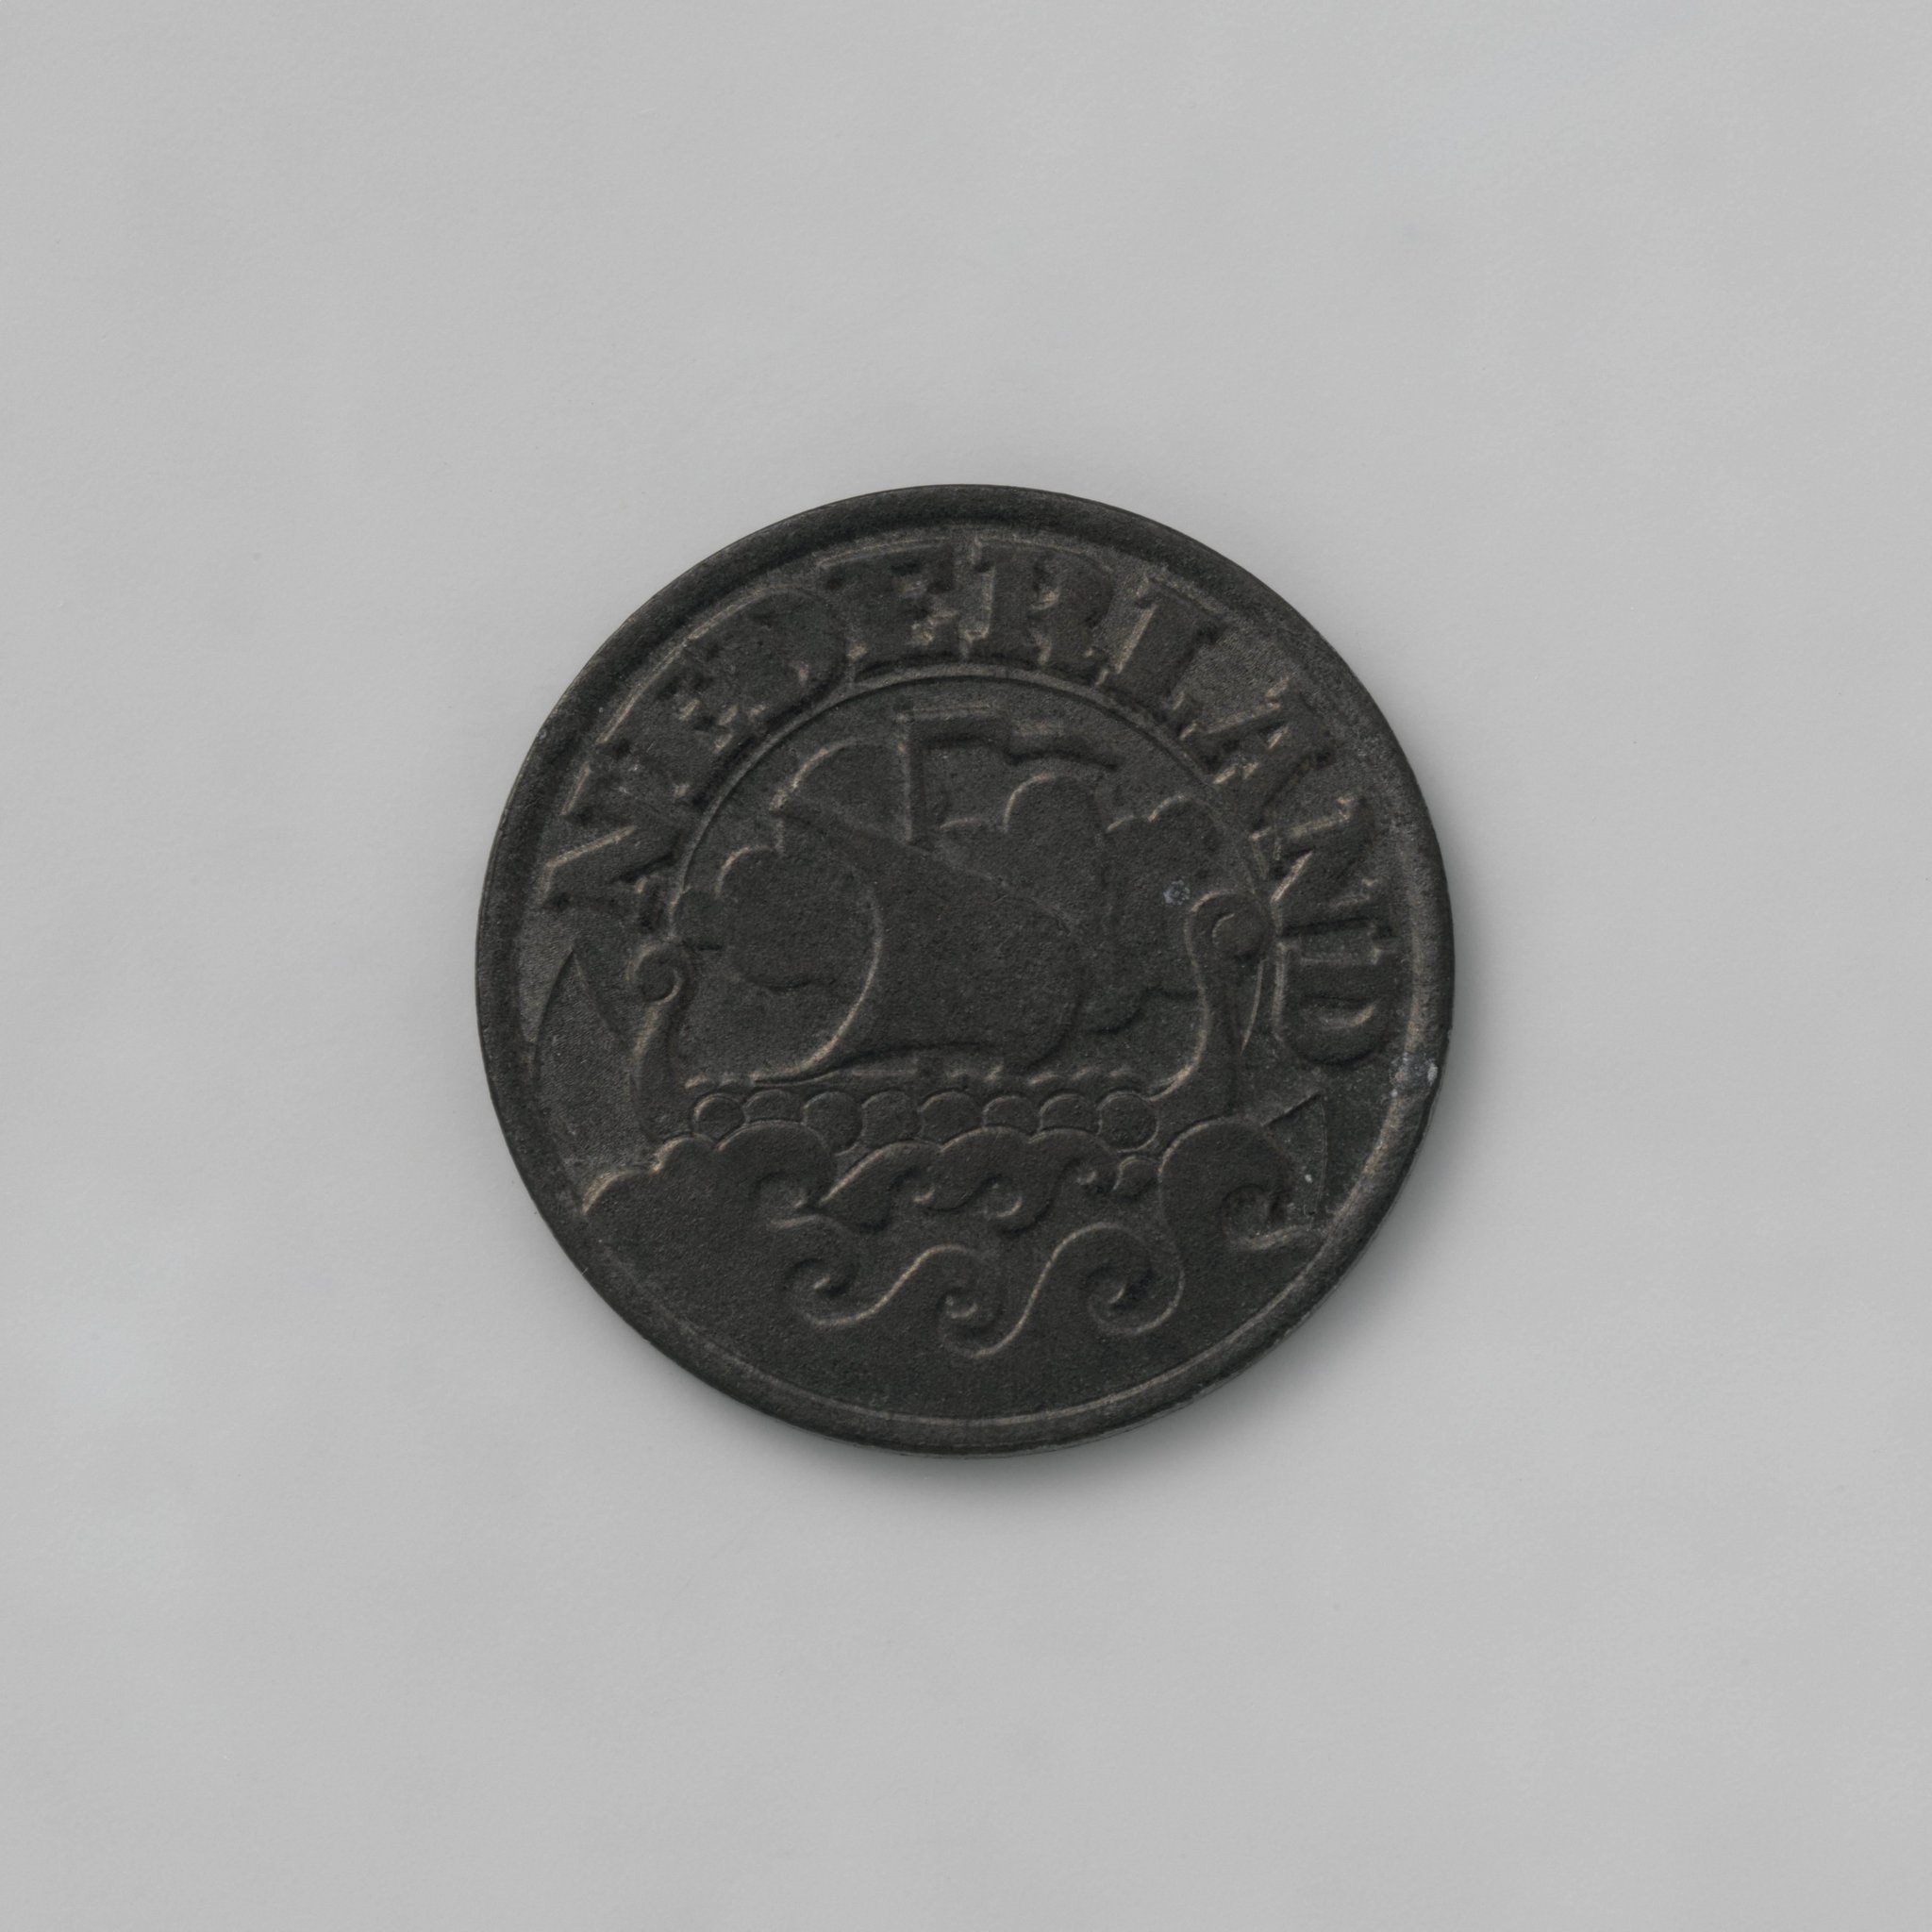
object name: coin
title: Nederlandse 25 cent, 1941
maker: Anonymous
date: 1941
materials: zinc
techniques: striking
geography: utrecht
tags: netherlands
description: Zinken munt. Voorzijde: zeilschip op zee. Keerzijde: tussen twee twijgen waarde-aanduiding 25 cents, waaronder jaartal. Gladde rand.